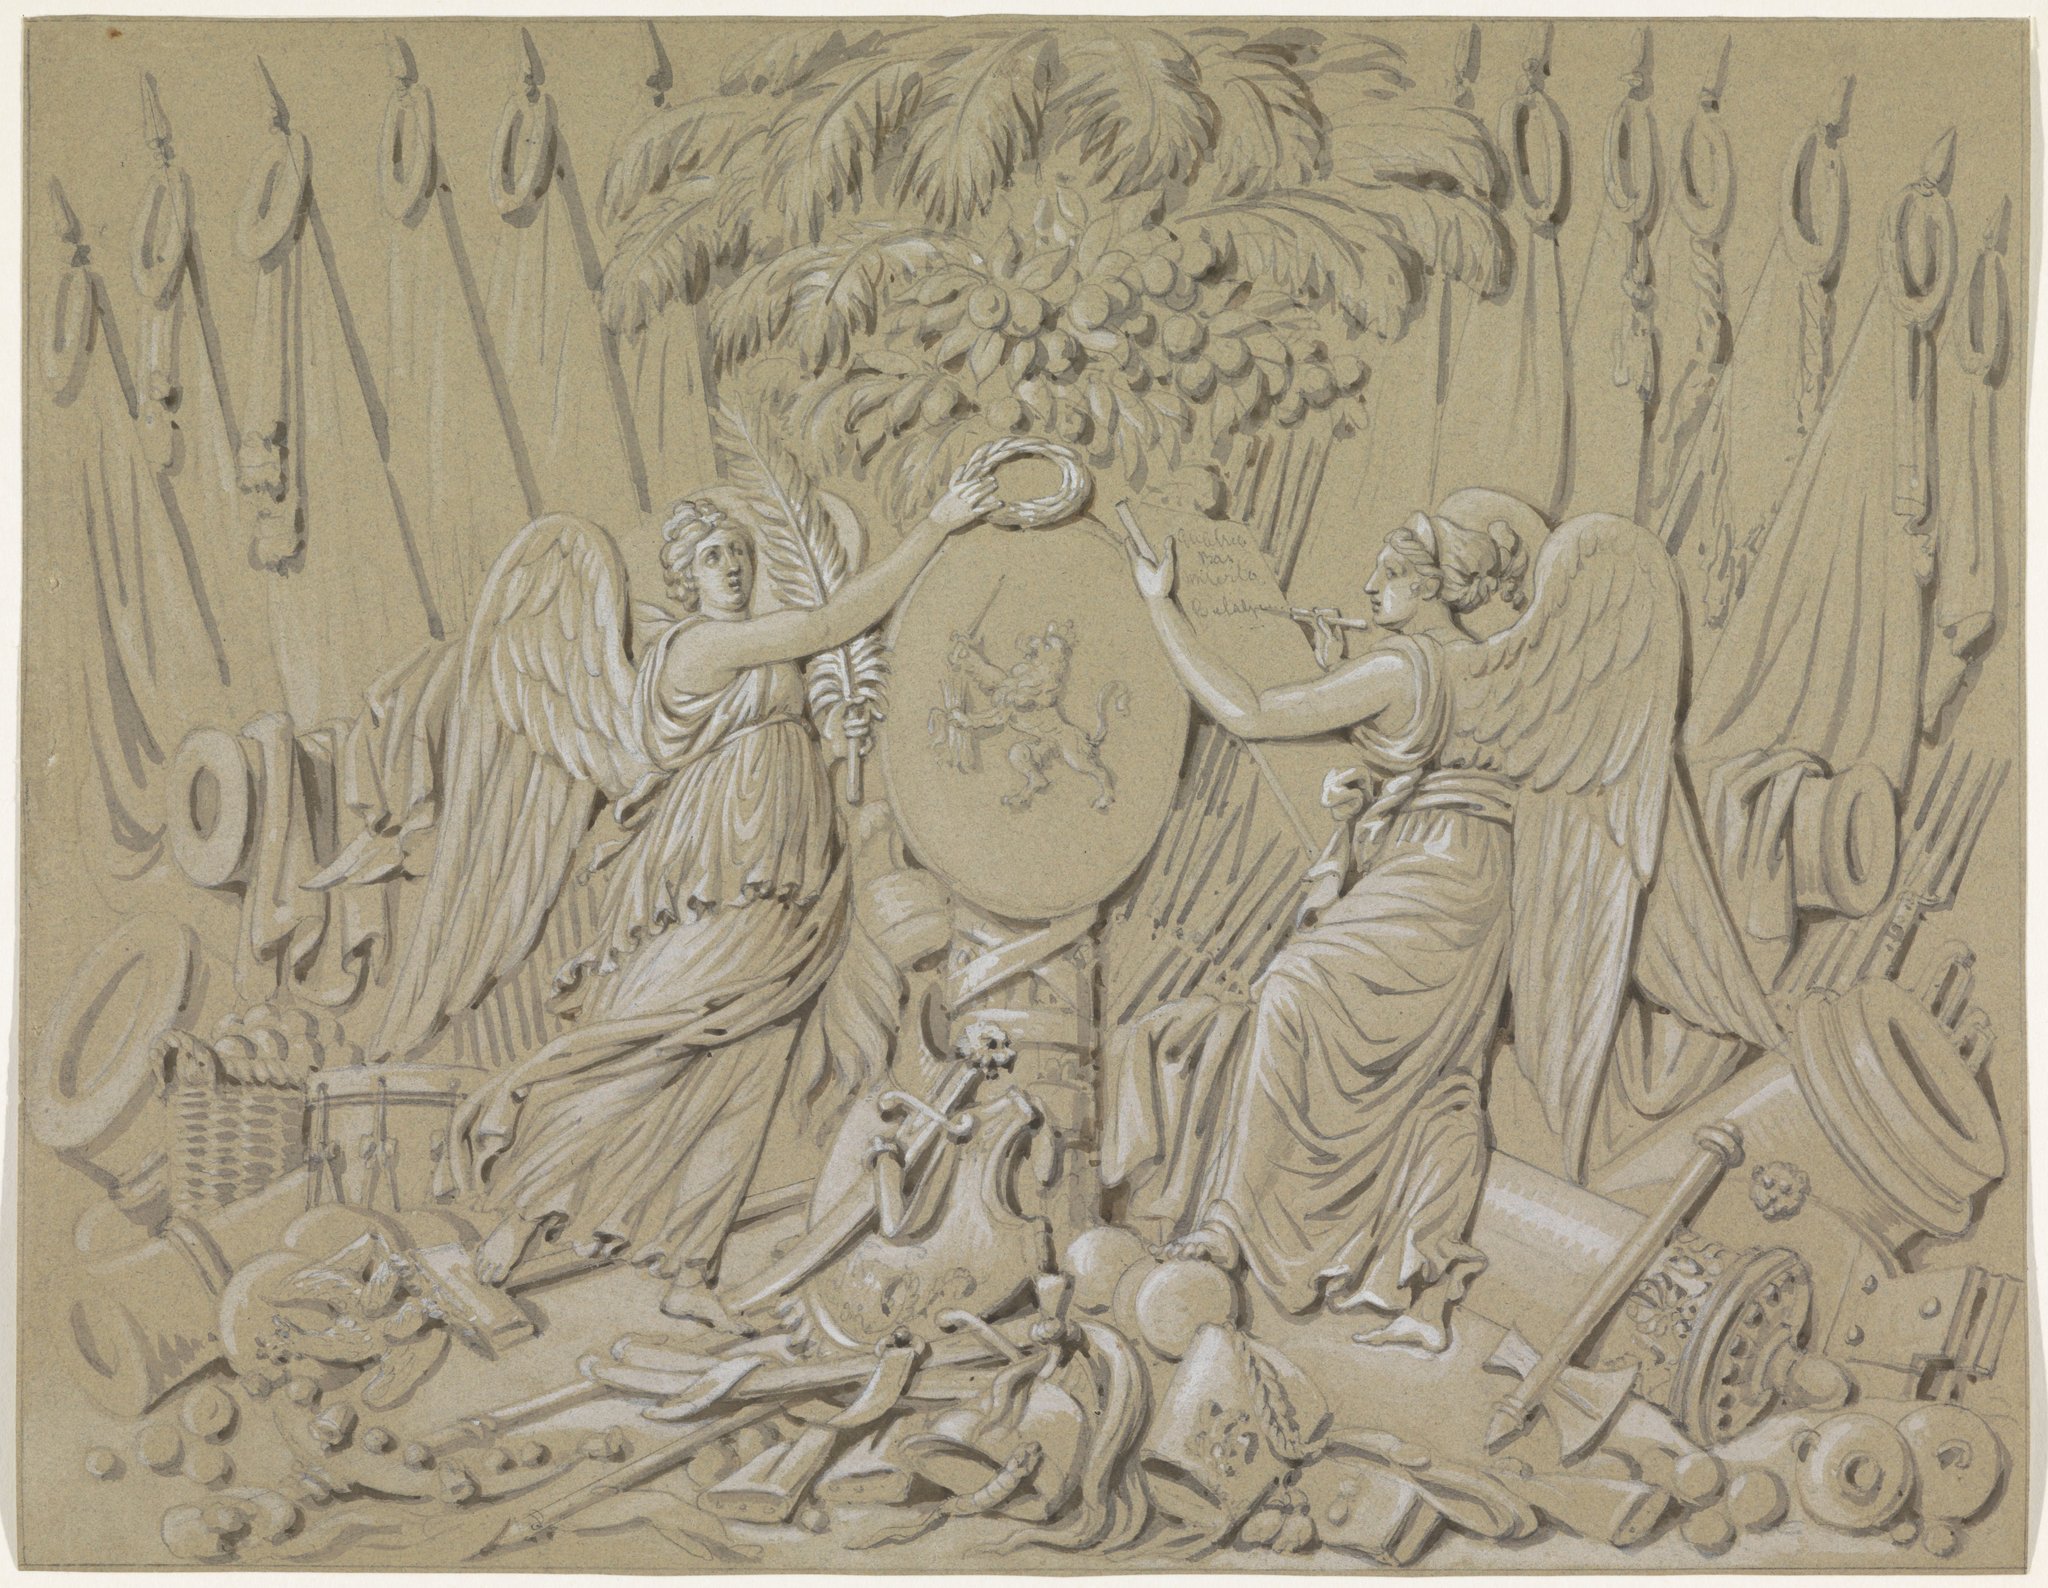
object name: drawing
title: Allegorie op de slag bij Waterloo, 1815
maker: Anonymous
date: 1815-1820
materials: ink, paint, paper, pencil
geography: netherlands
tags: 'victoria'; 'vittoria', 'vittoria navale', 'vittoria degl'antichi' (ripa), 'historia'; 'historia' (ripa)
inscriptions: collector's mark: Lugt 2228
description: Allegorie op de overwinning in de Slag bij Waterloo op 18 juni 1815. De gevleugelde Overwinning houdt een lauwerkrans boven een wapenschild met de Nederlandse leeuw, rechts legt de Geschiedenis de gebeurtenissen vast. Tegen een achtergrond met een boom, vaandels en wapens. Op de grond liggen de wapens van de verslagen Fransen. Onderdeel van een groep van drie allegorische tekeningen op de slag bij Waterloo.